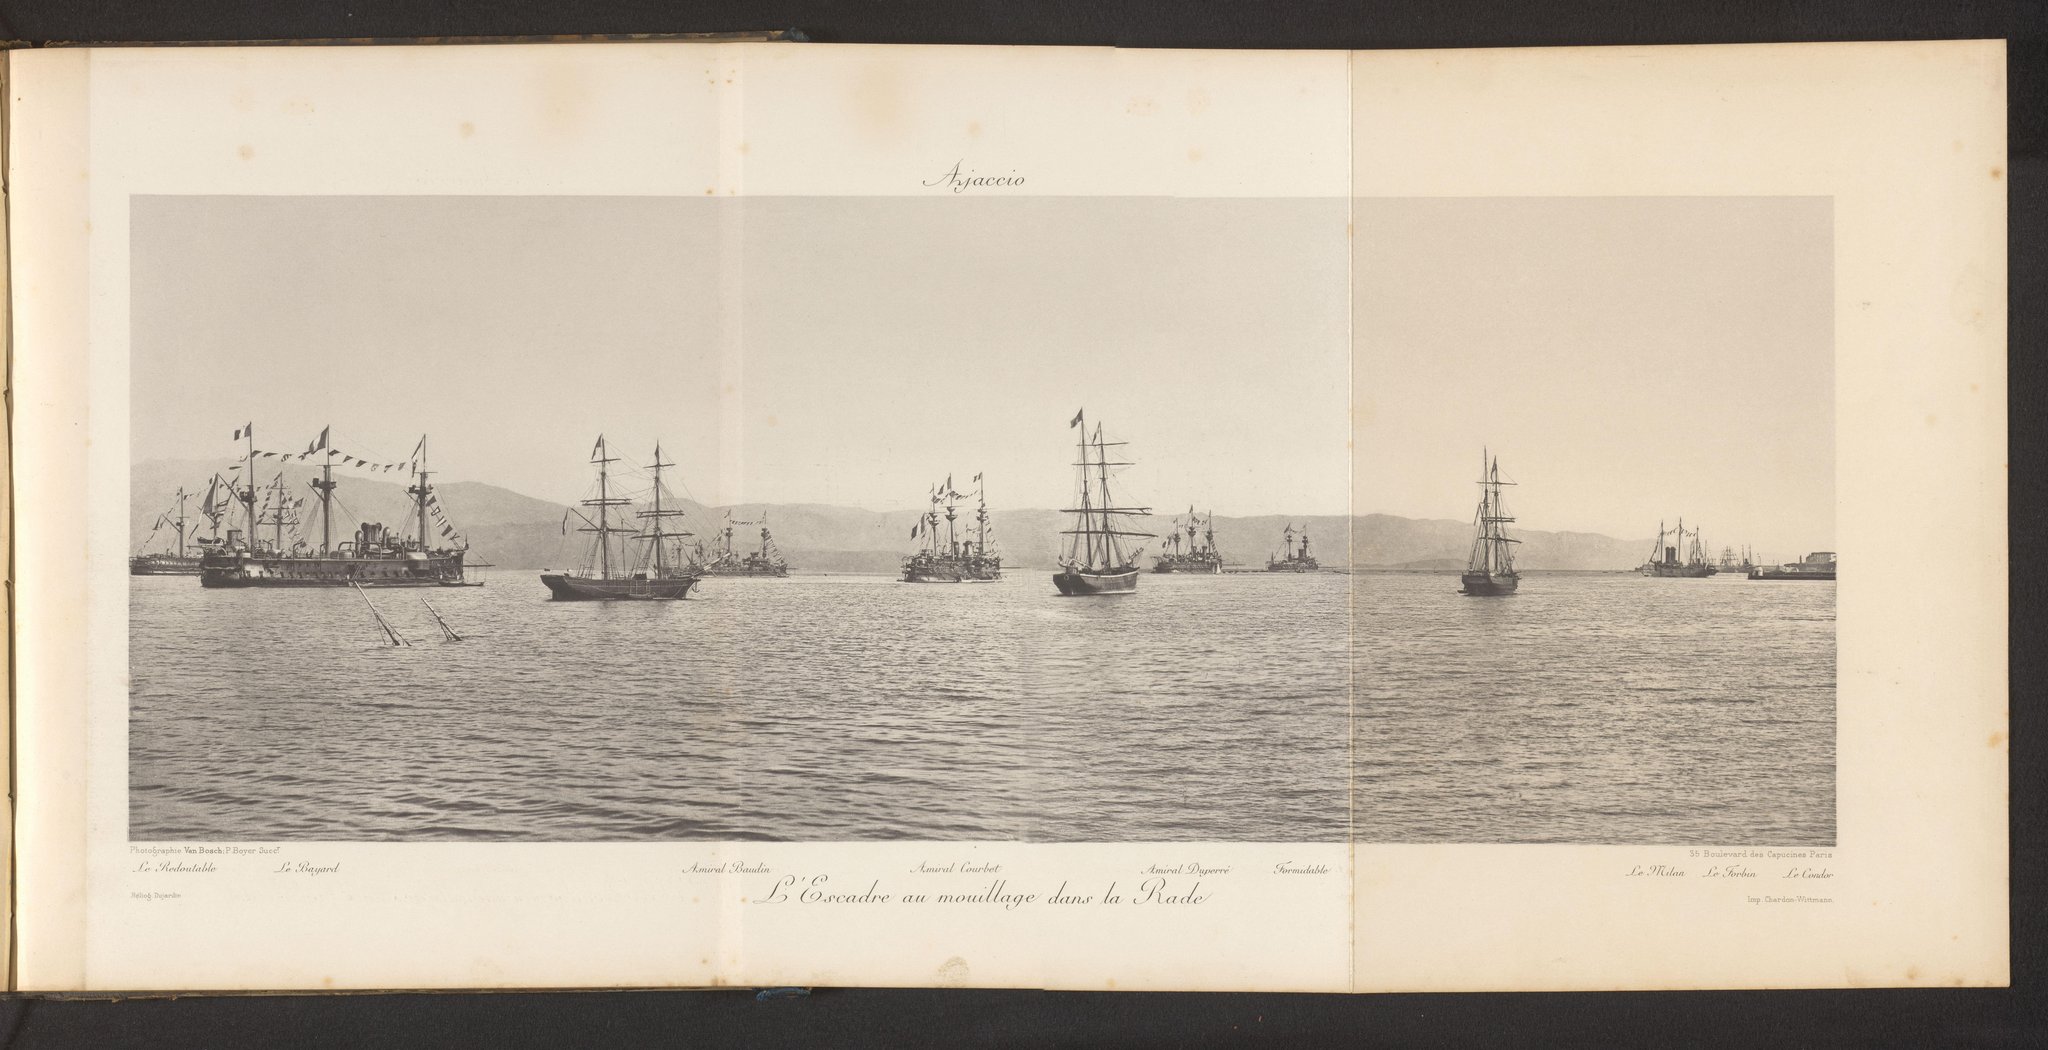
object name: page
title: Eskader voor anker voor de kust bij Ajaccio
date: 1888-1890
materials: paper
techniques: photoaquatint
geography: ajaccio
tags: ships (in general)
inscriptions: inscription: ‘Ajaccio’, inscription: ‘35 Boulevard des Capucines Paris’, inscription: ‘Le Redoutable (...) Le Condor’